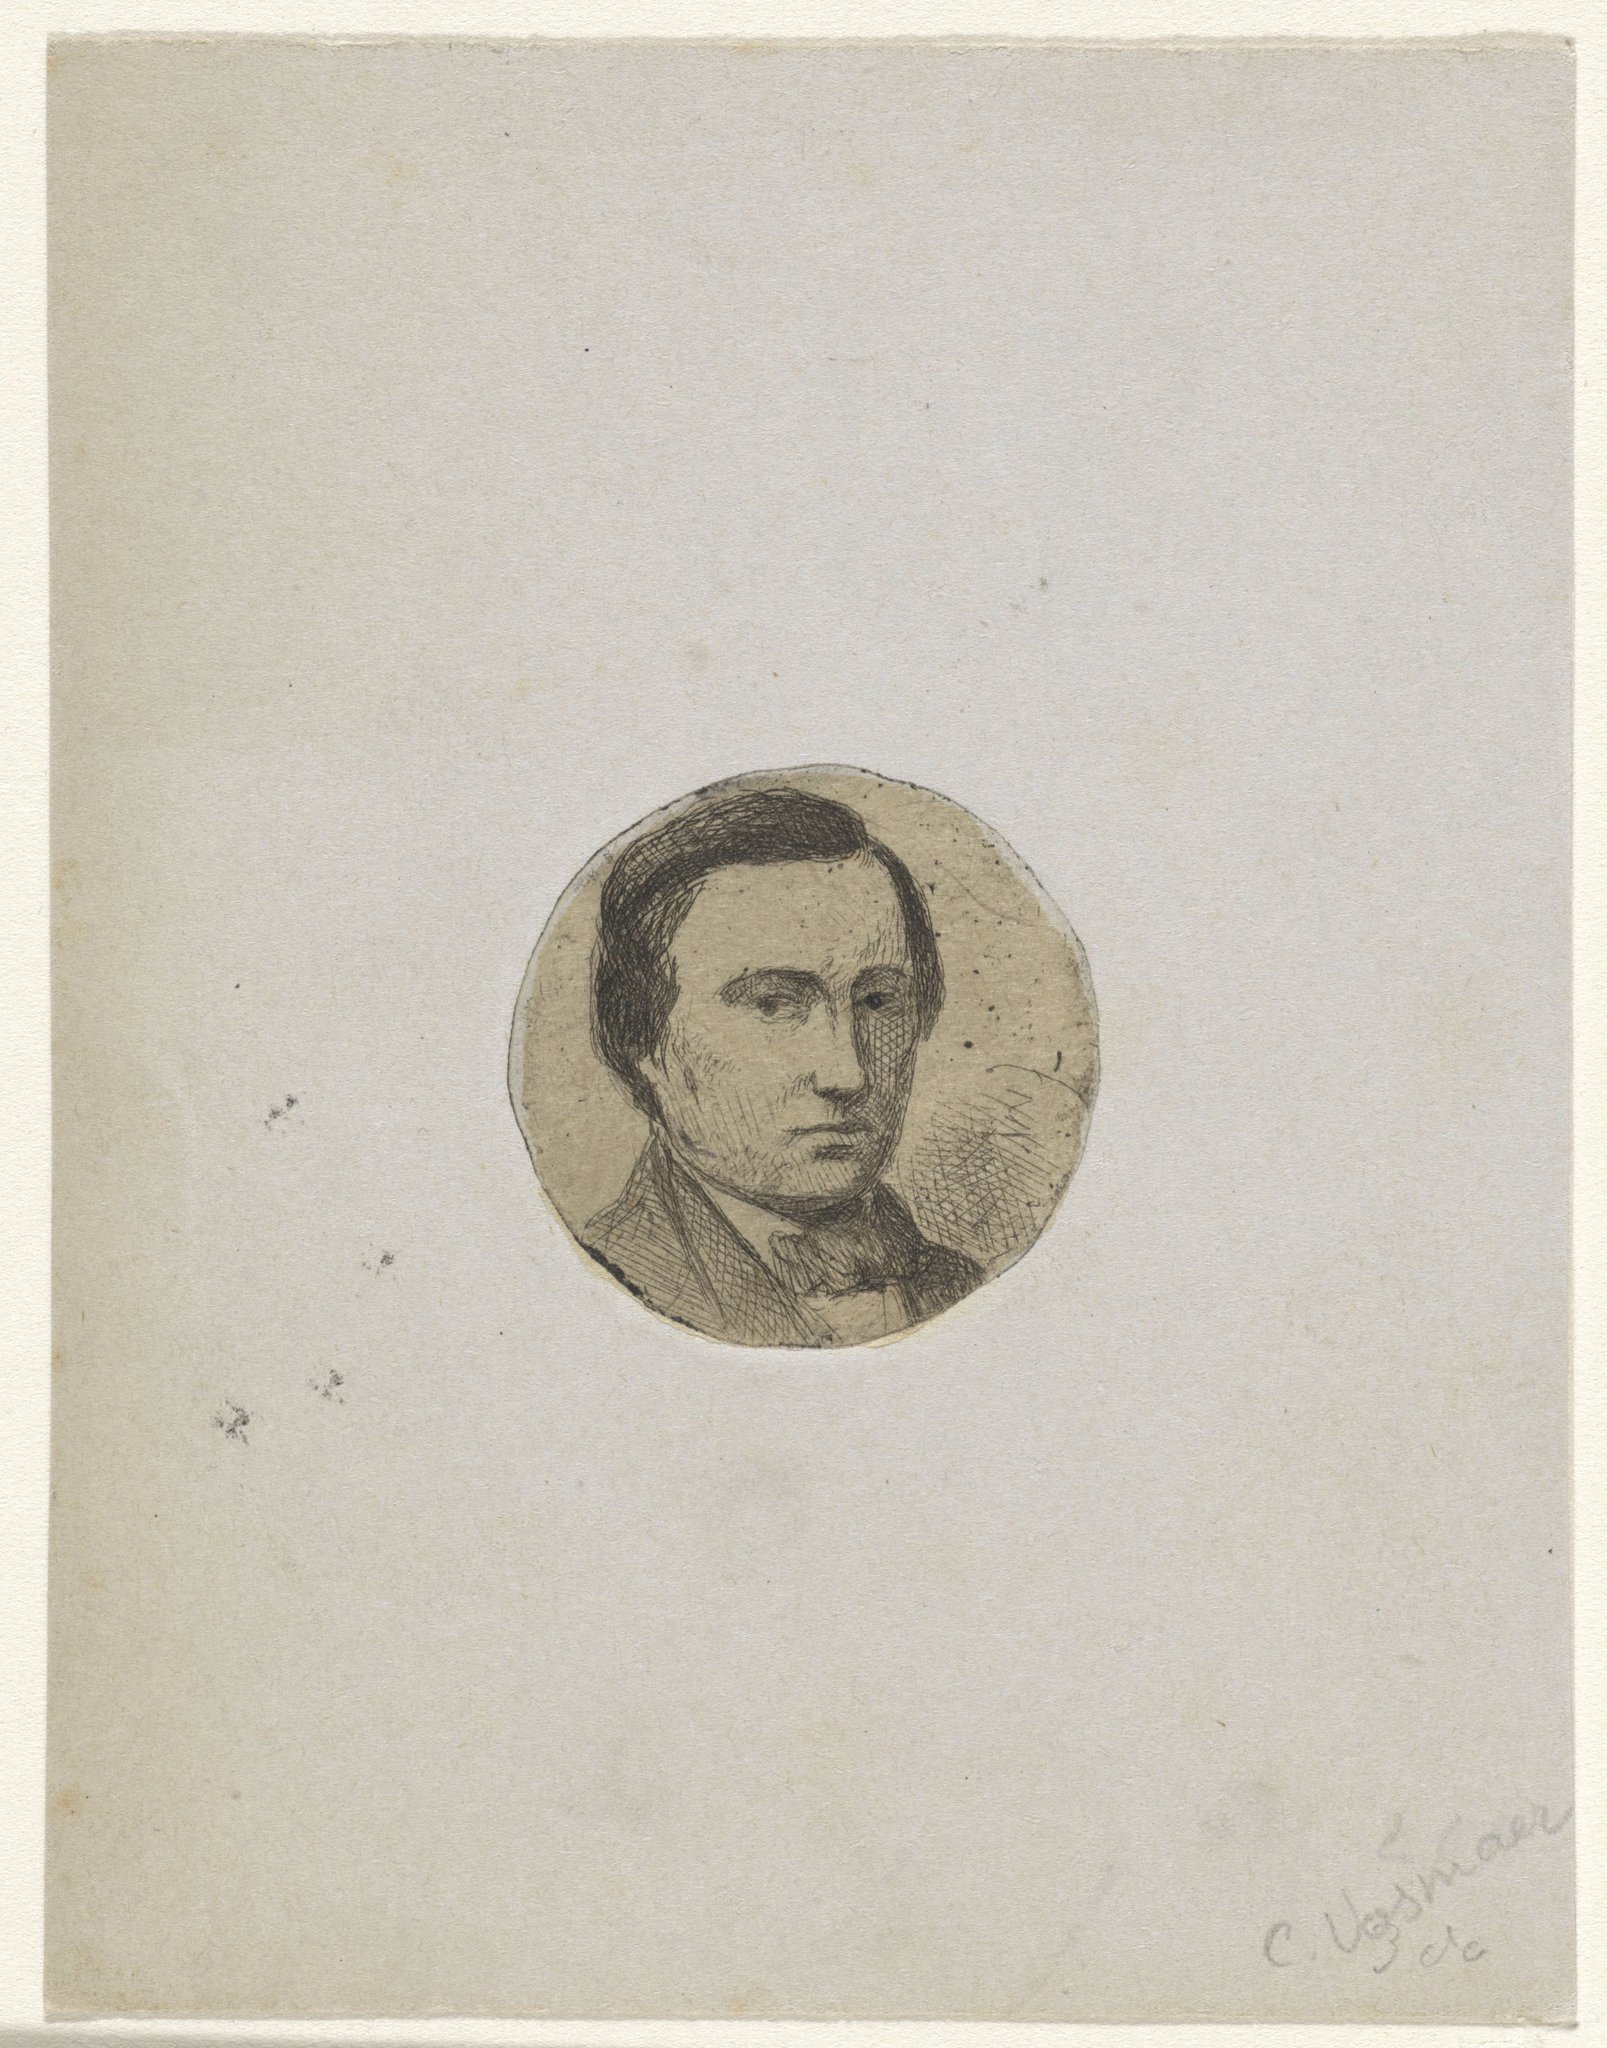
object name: print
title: Portret van Carel Vosmaer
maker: jan weissenbruch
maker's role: painter, print maker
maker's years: 1822-1880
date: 1837-1880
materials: paper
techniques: etching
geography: the hague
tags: the hague, print maker, draughtsman, carel vosmaer, historical persons, portrait, self-portrait of artist